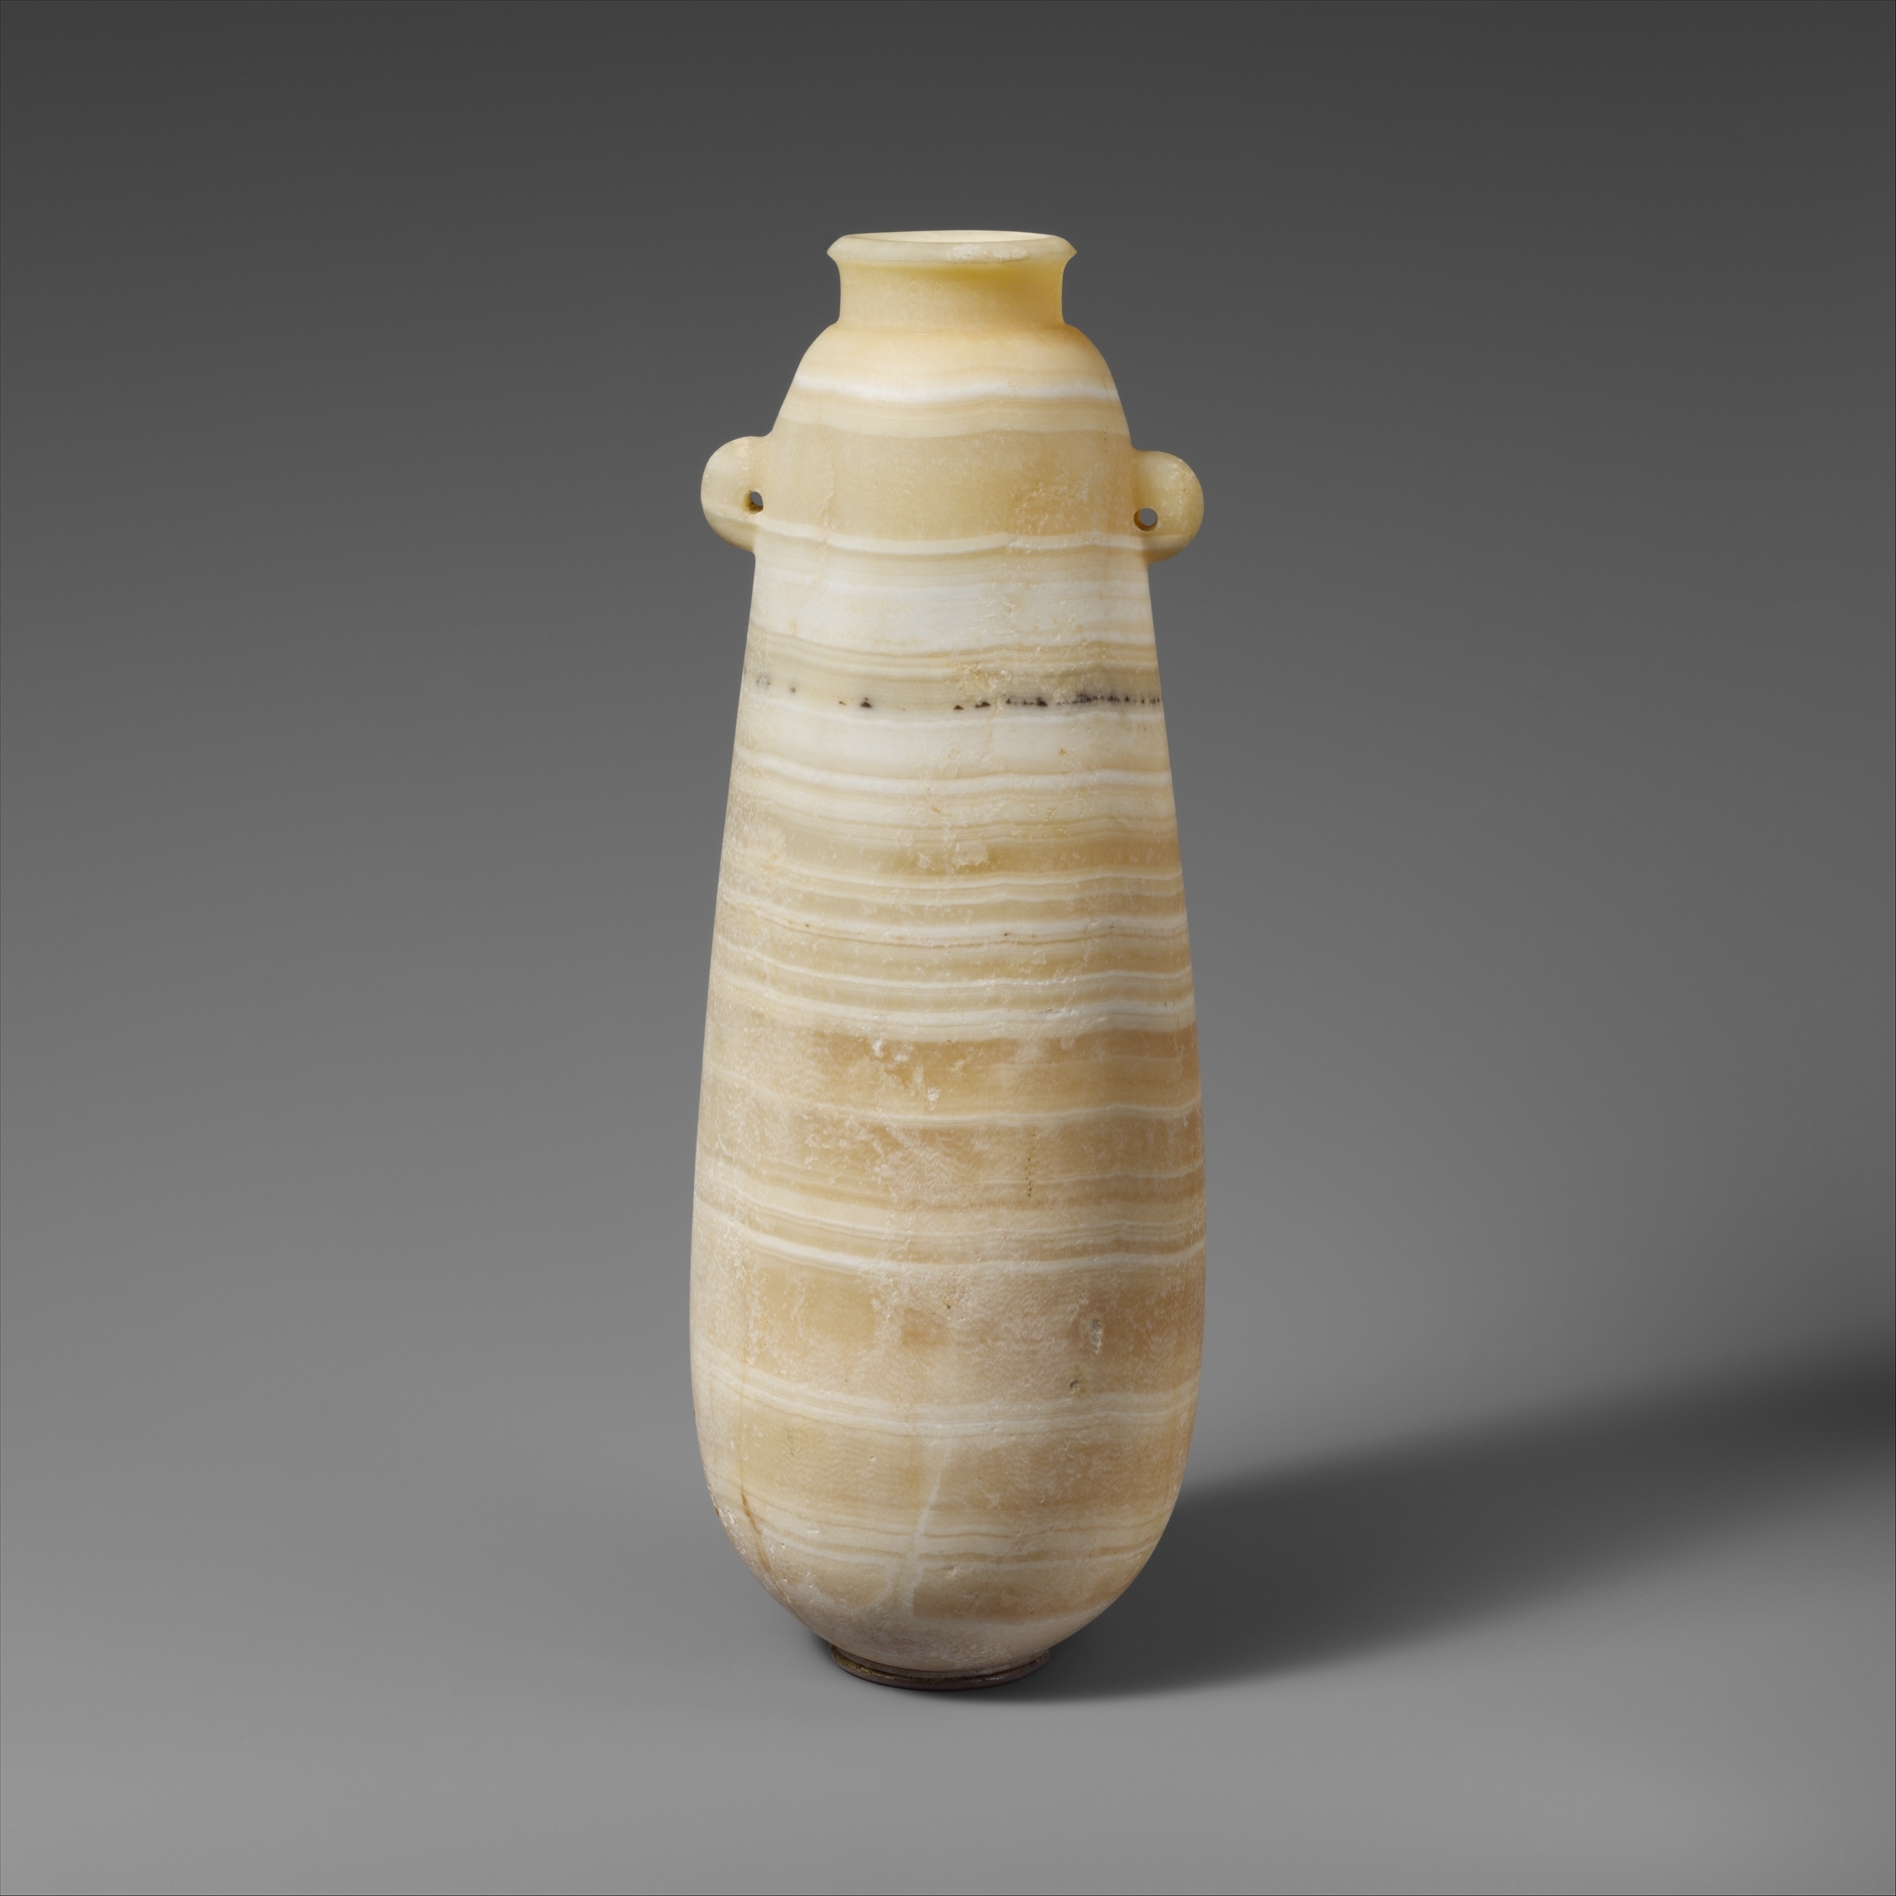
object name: alabastron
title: Alabaster alabastron (perfume vase)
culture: cypriot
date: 600-401 BCE